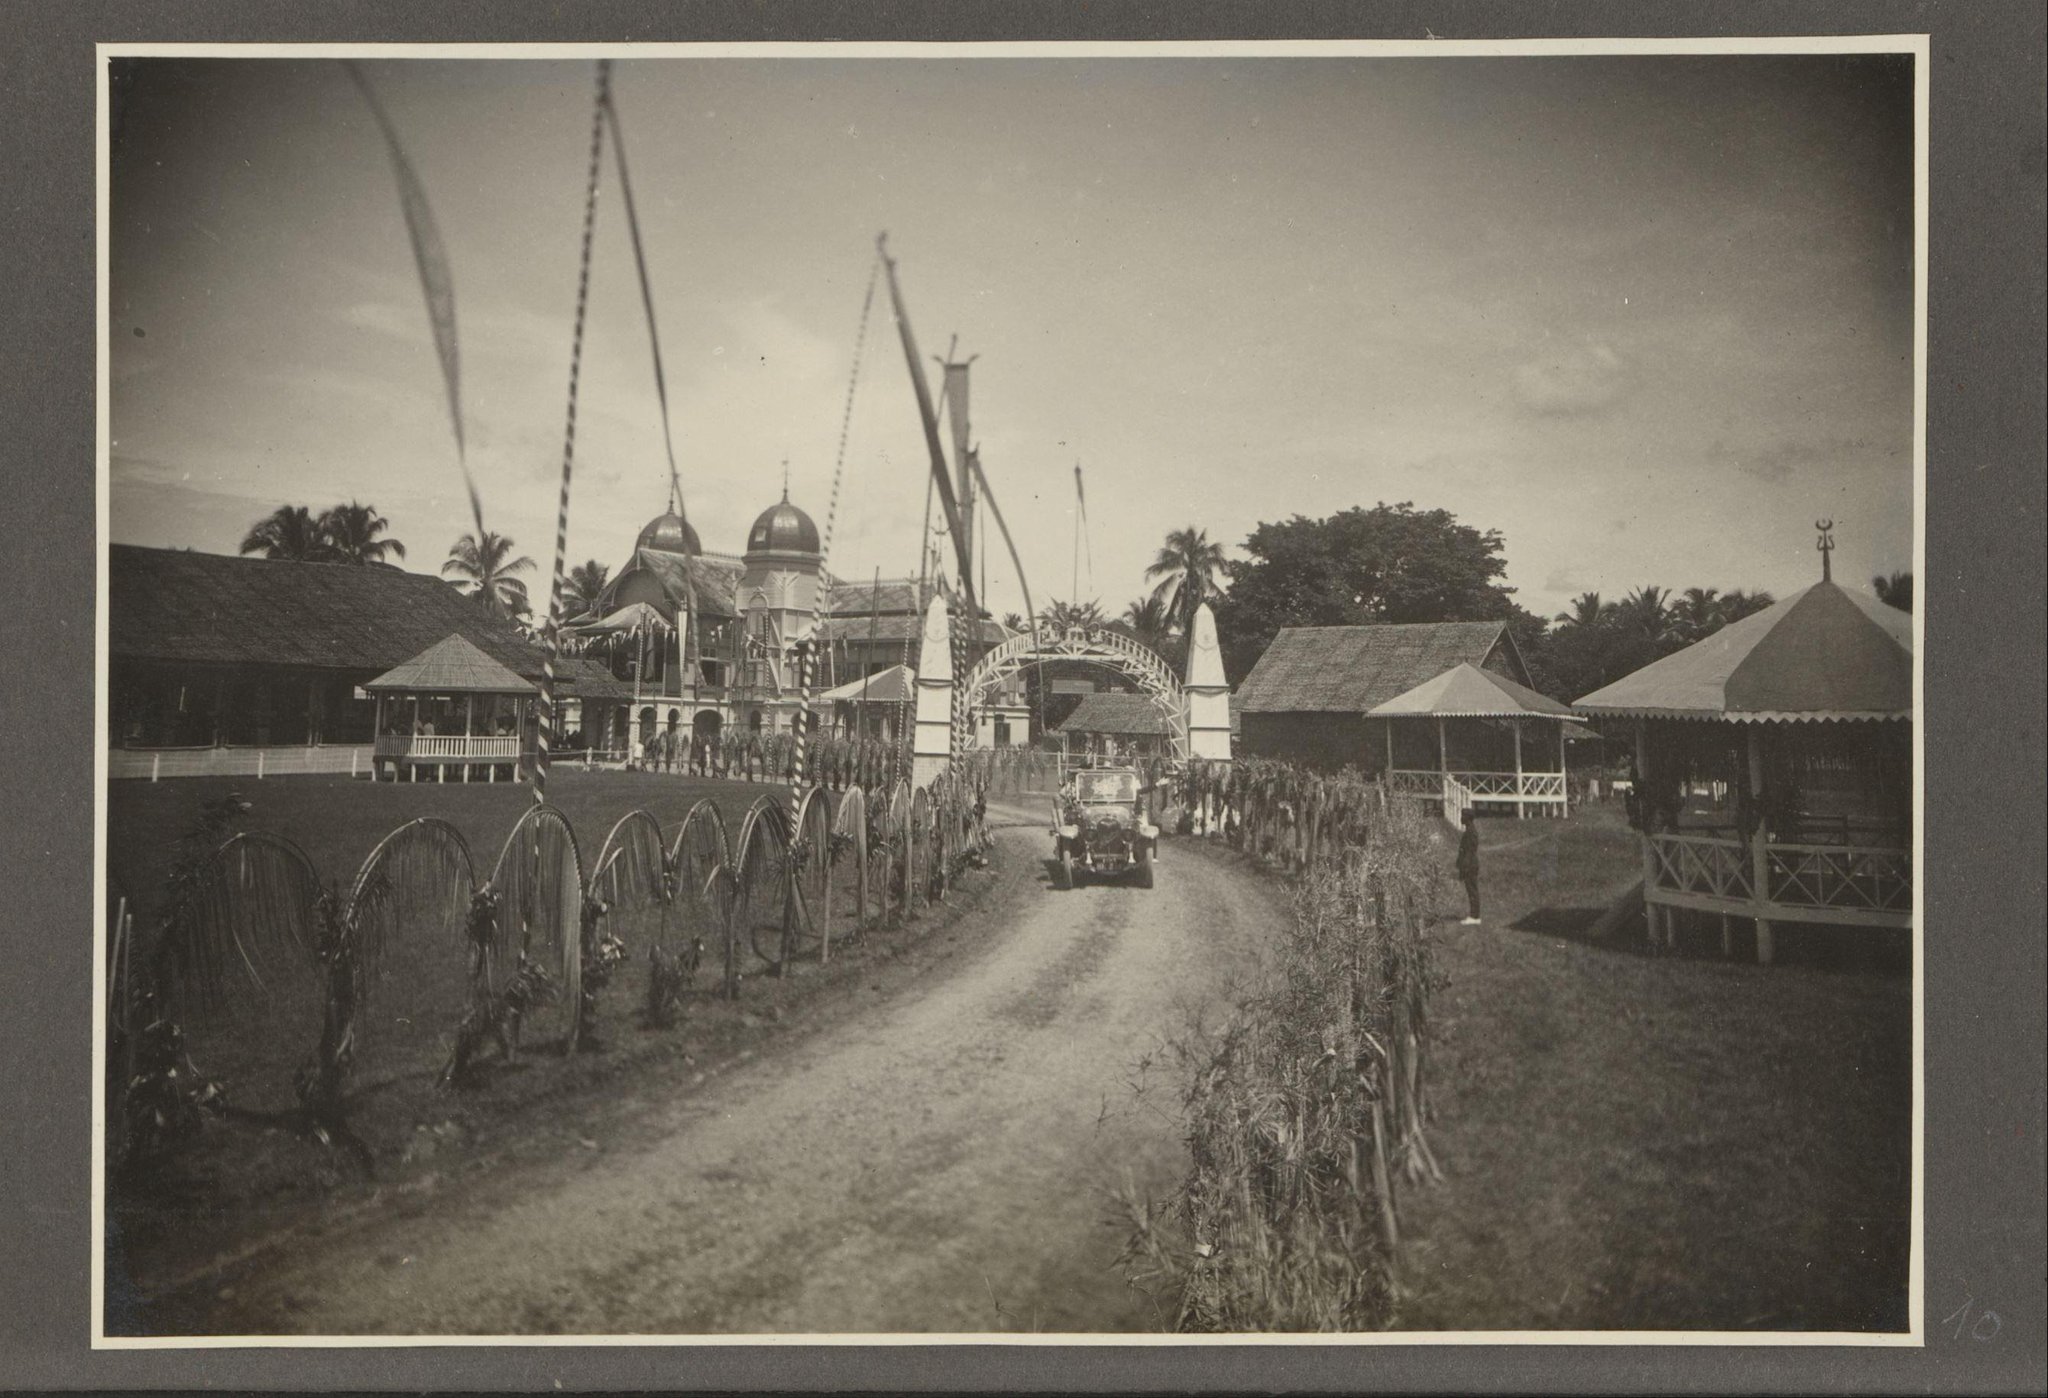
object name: album leaf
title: Toegangsweg met de auto van de Sultan naar het paleis van de Sultan van Langkat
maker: Anonymous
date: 1919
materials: photographic support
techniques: gelatin silver print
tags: road, path, automobile, sumatra